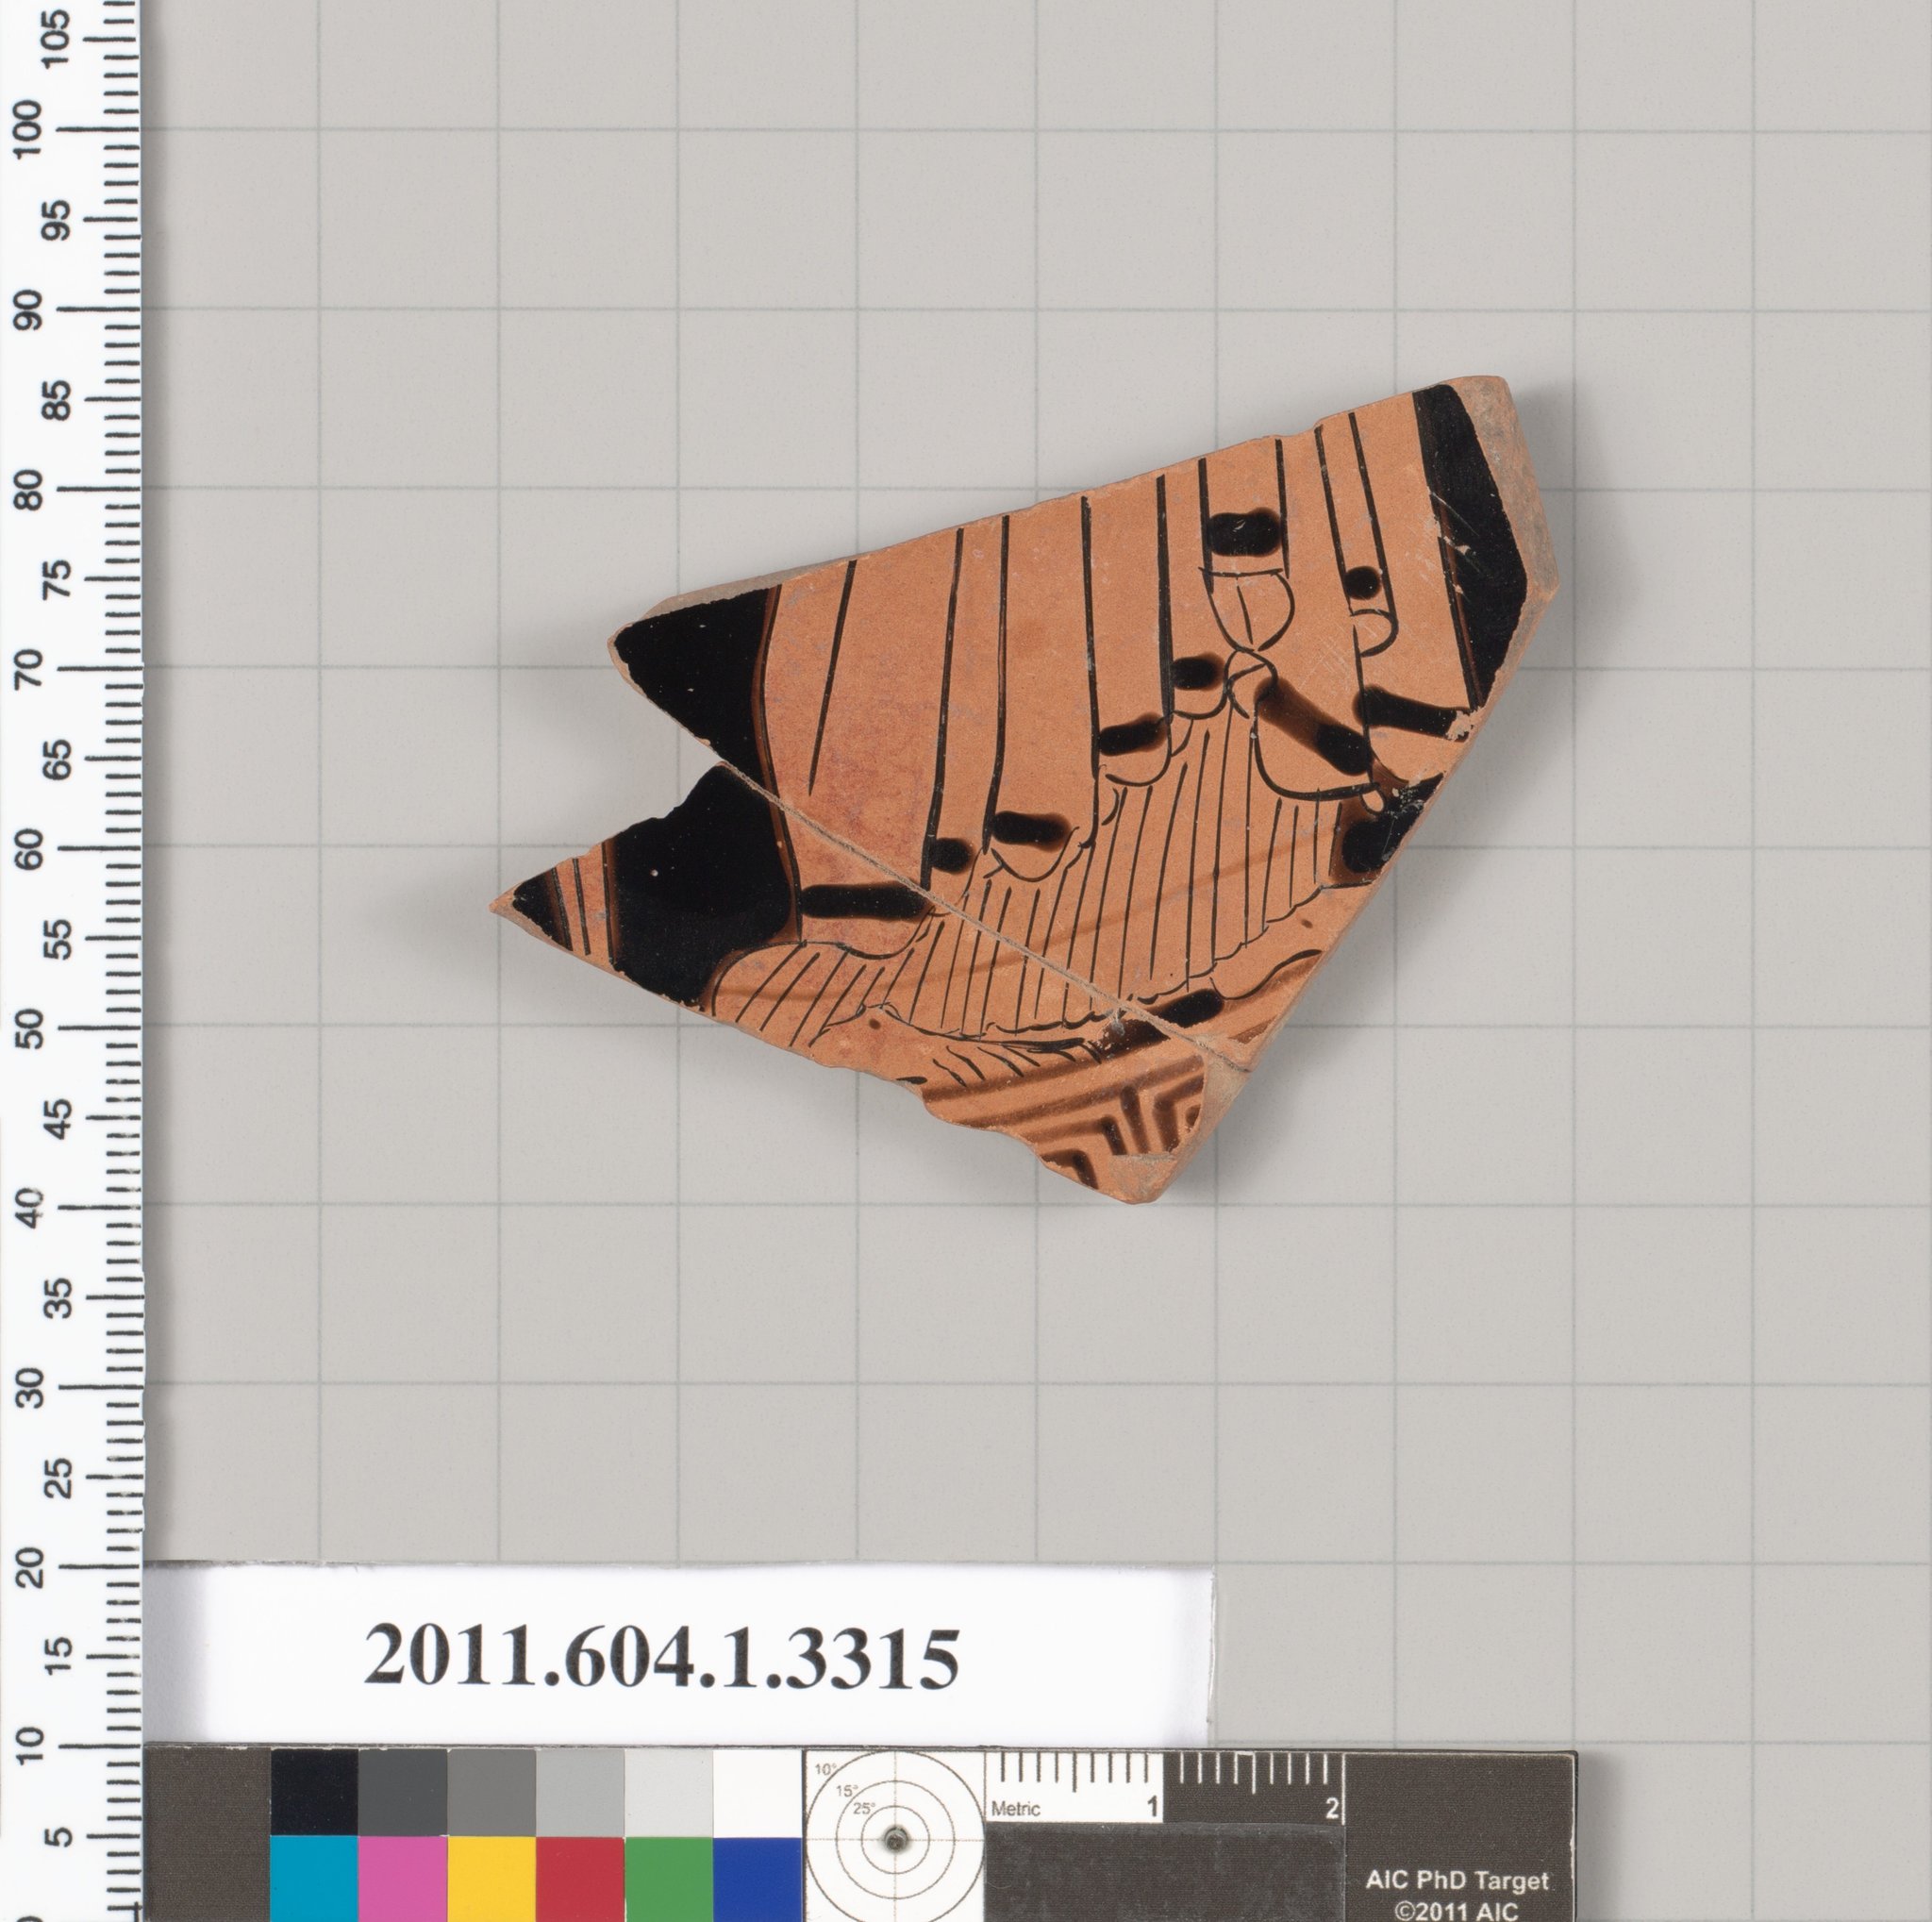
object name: kylix fragment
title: Terracotta fragment of a kylix (drinking cup)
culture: greek, attic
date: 475-451 BCE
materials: terracotta